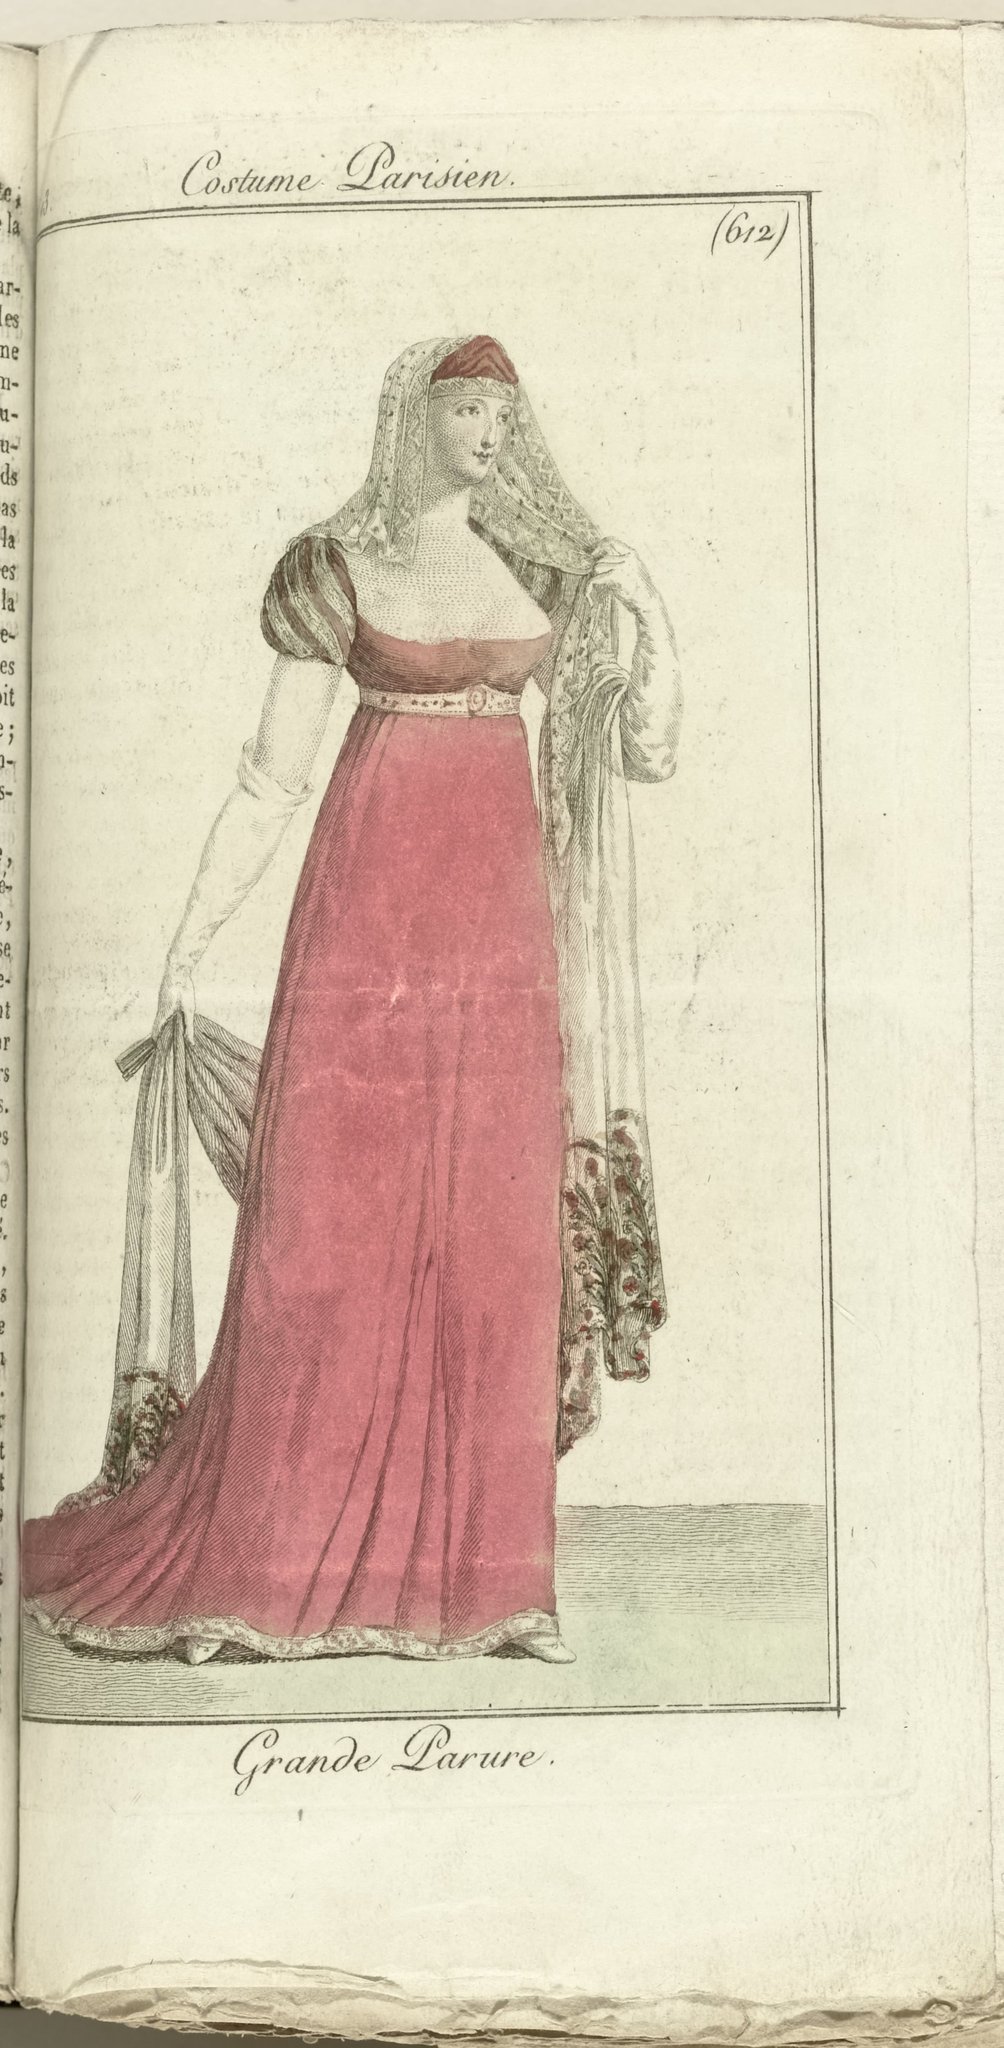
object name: fashion print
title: Journal des Dames et des Modes, Costume Parisien, 1805, An 13 (612) Grande Parure.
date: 1805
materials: paper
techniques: engraving, hand coloring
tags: veil (+ women's clothes), neck-gear ~ clothing (shawl) (+ women's clothes), fashion plates, dress, gown (+ women's clothes)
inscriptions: title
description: Vrouw in 'Grande Parure'. Roze japon met laag decolleté en sleep. Sluier los over het hoofd gedrapeerd. Omslagdoek over de arm. De prent maakt deel uit van het modetijdschrift Journal des Dames et des Modes, uitgegeven door Pierre de la Mésangère, Parijs, 1797-1839.